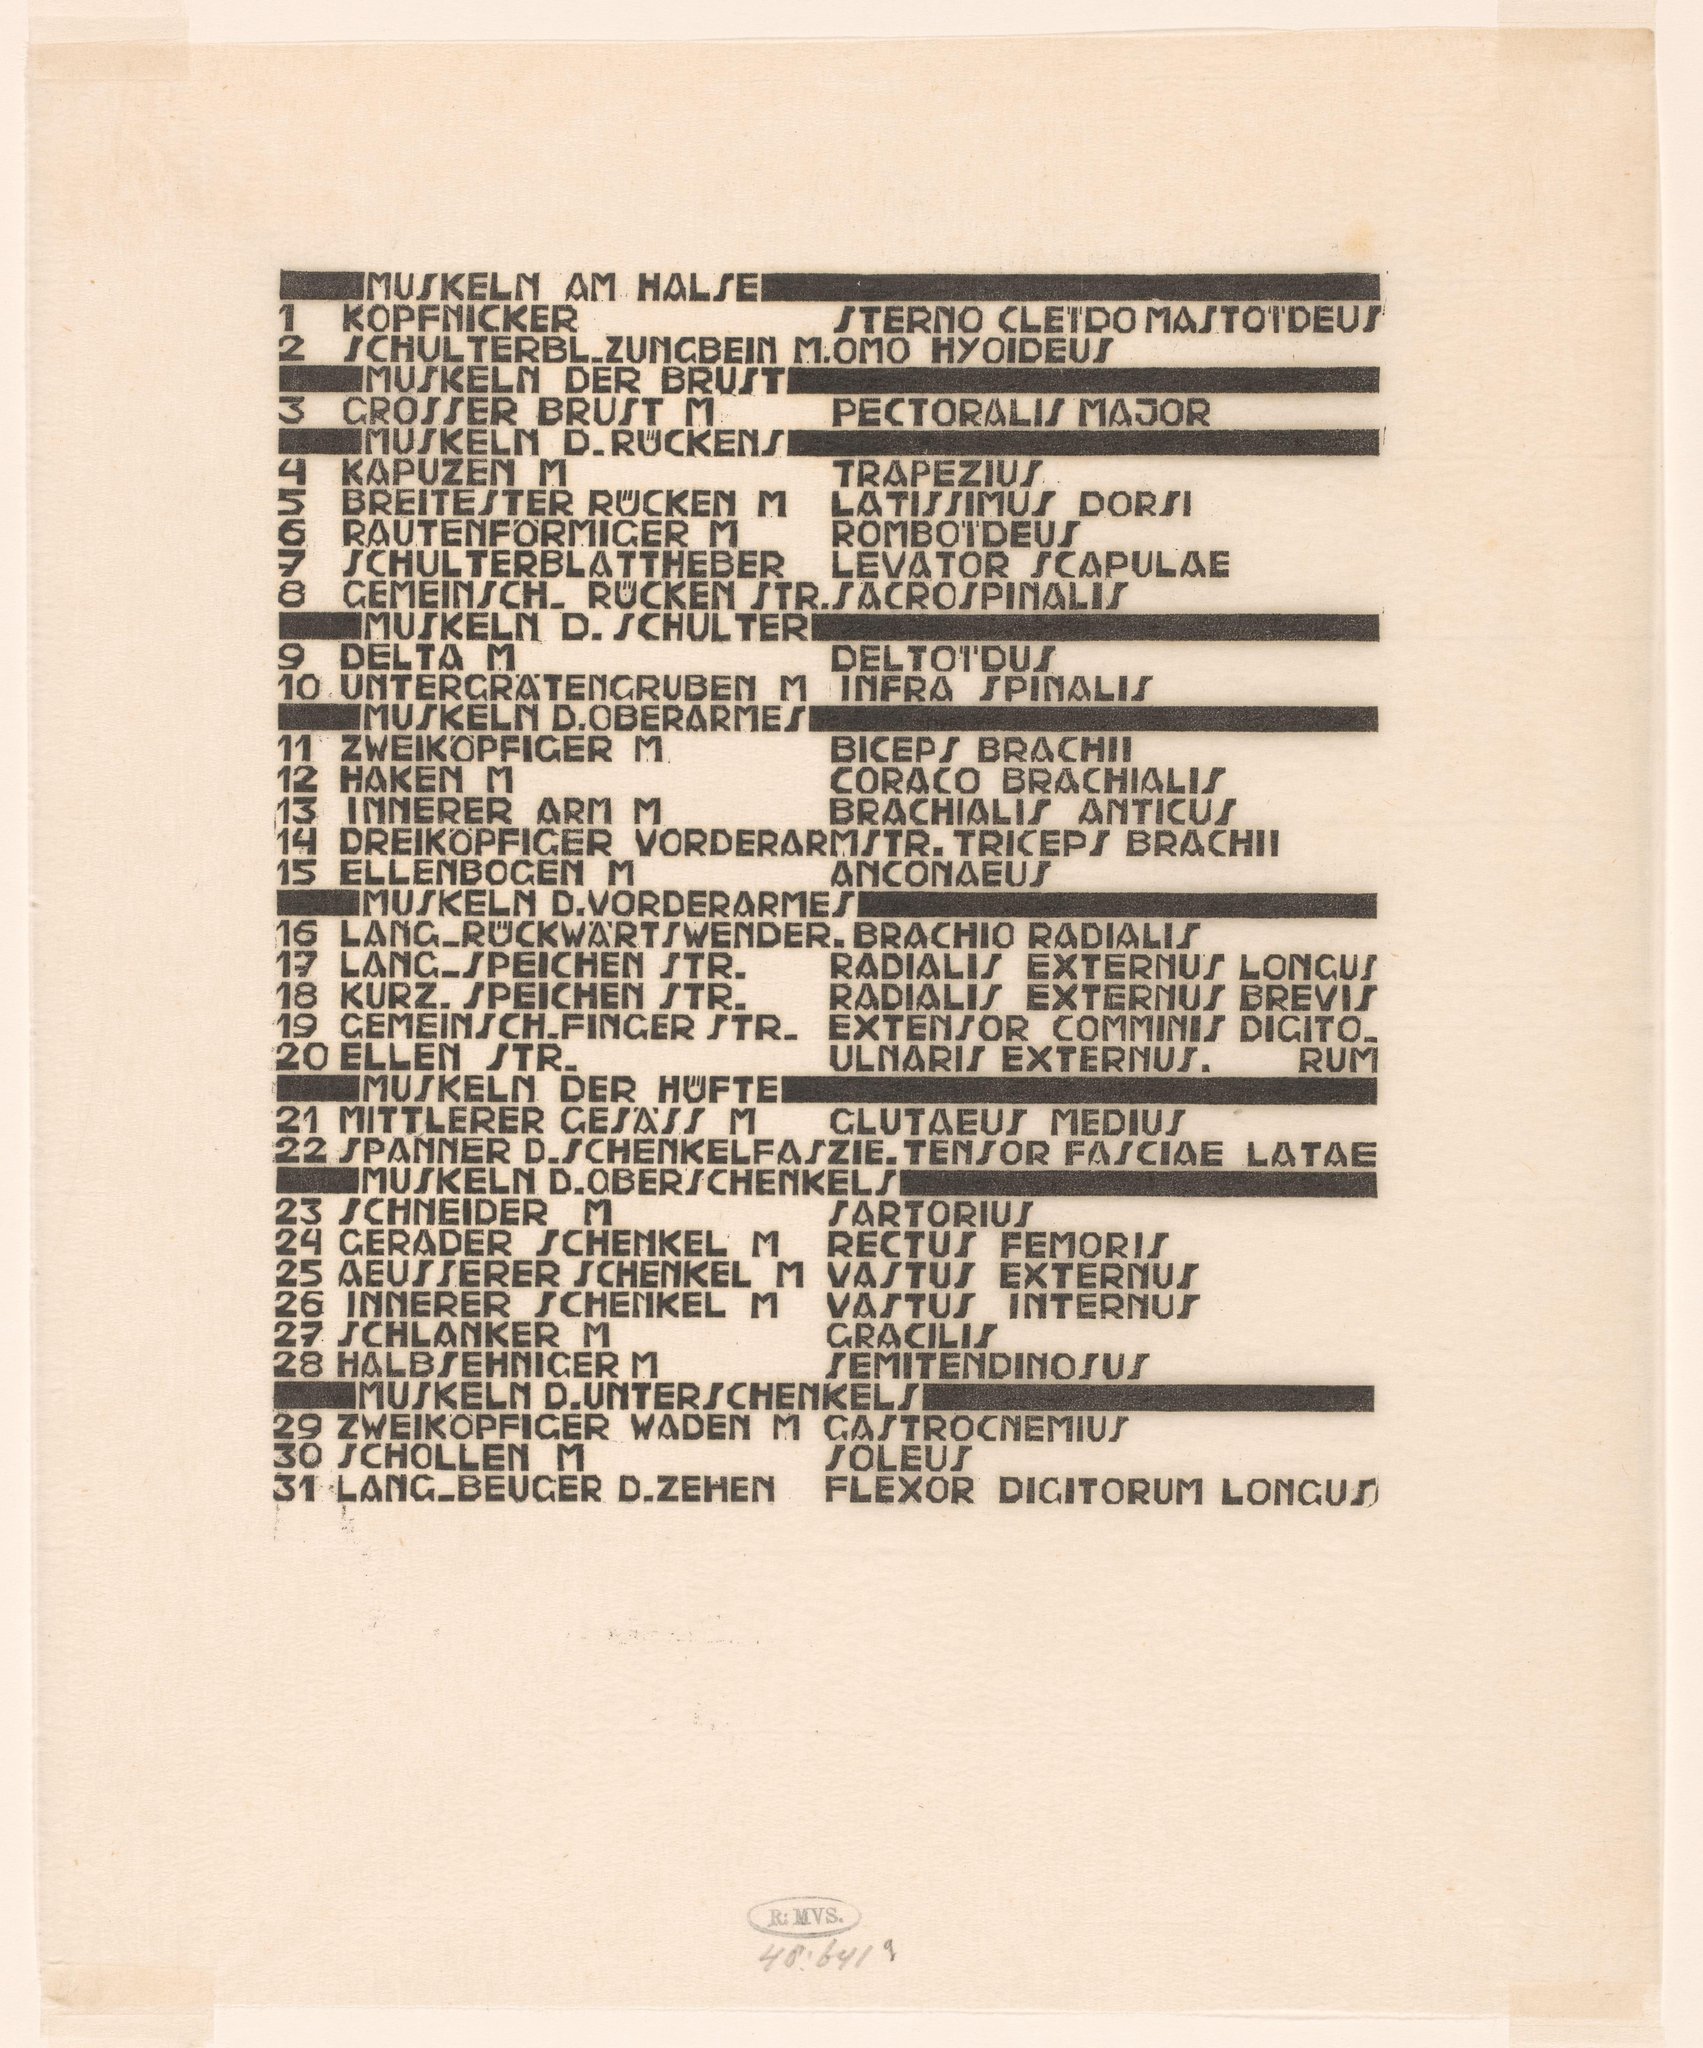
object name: print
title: Lijst van hals-, arm- en zijspieren in Duits en Latijn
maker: reijer stolk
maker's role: draughtsman, print maker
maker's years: 1896-1945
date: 1906-1945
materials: paper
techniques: woodcut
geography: netherlands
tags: muscles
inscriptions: collector's mark: Lugt 2228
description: Prent mogelijk gebruikt voor: Stolk, Reyer. Anatomische studies in houtsneden. Amsterdam: G.W. Breughel, 1946.